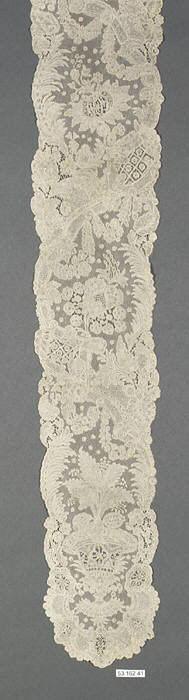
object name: lappet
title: Pair of lappets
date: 1701-1800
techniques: lace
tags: flowers